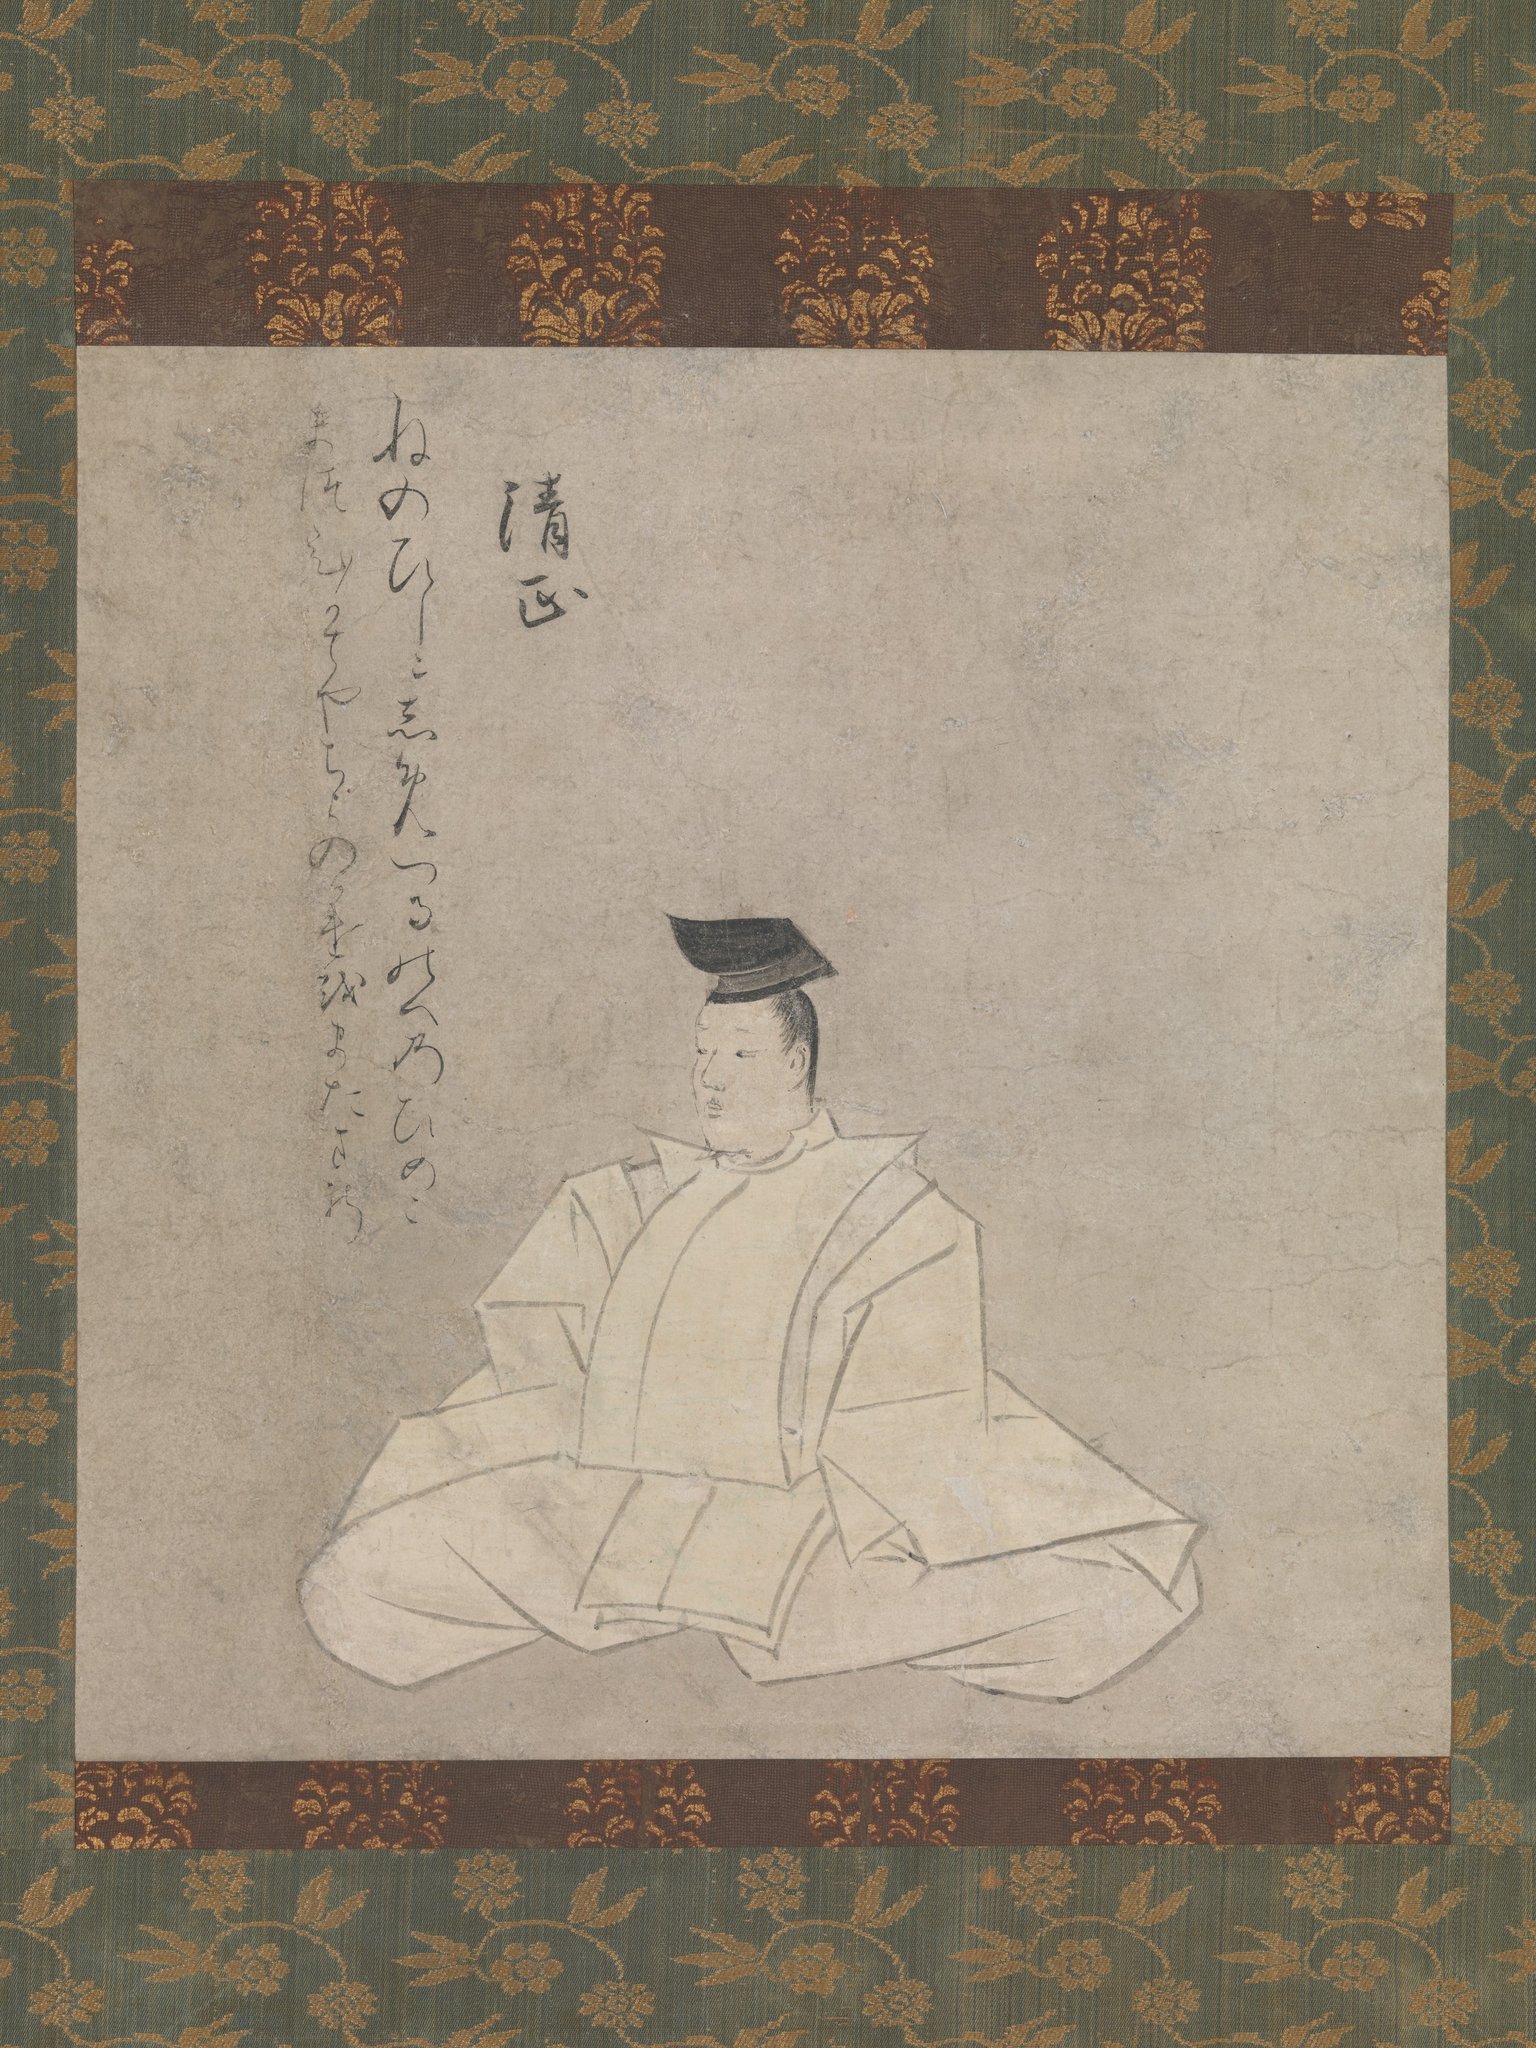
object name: hanging scroll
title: The Poet Fujiwara Kiyotada, from the “Narikane Version” of Thirty-six Poetic Immortals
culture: japanese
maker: unidentified artist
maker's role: artist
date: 1201-1300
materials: ink, paper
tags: men,poets